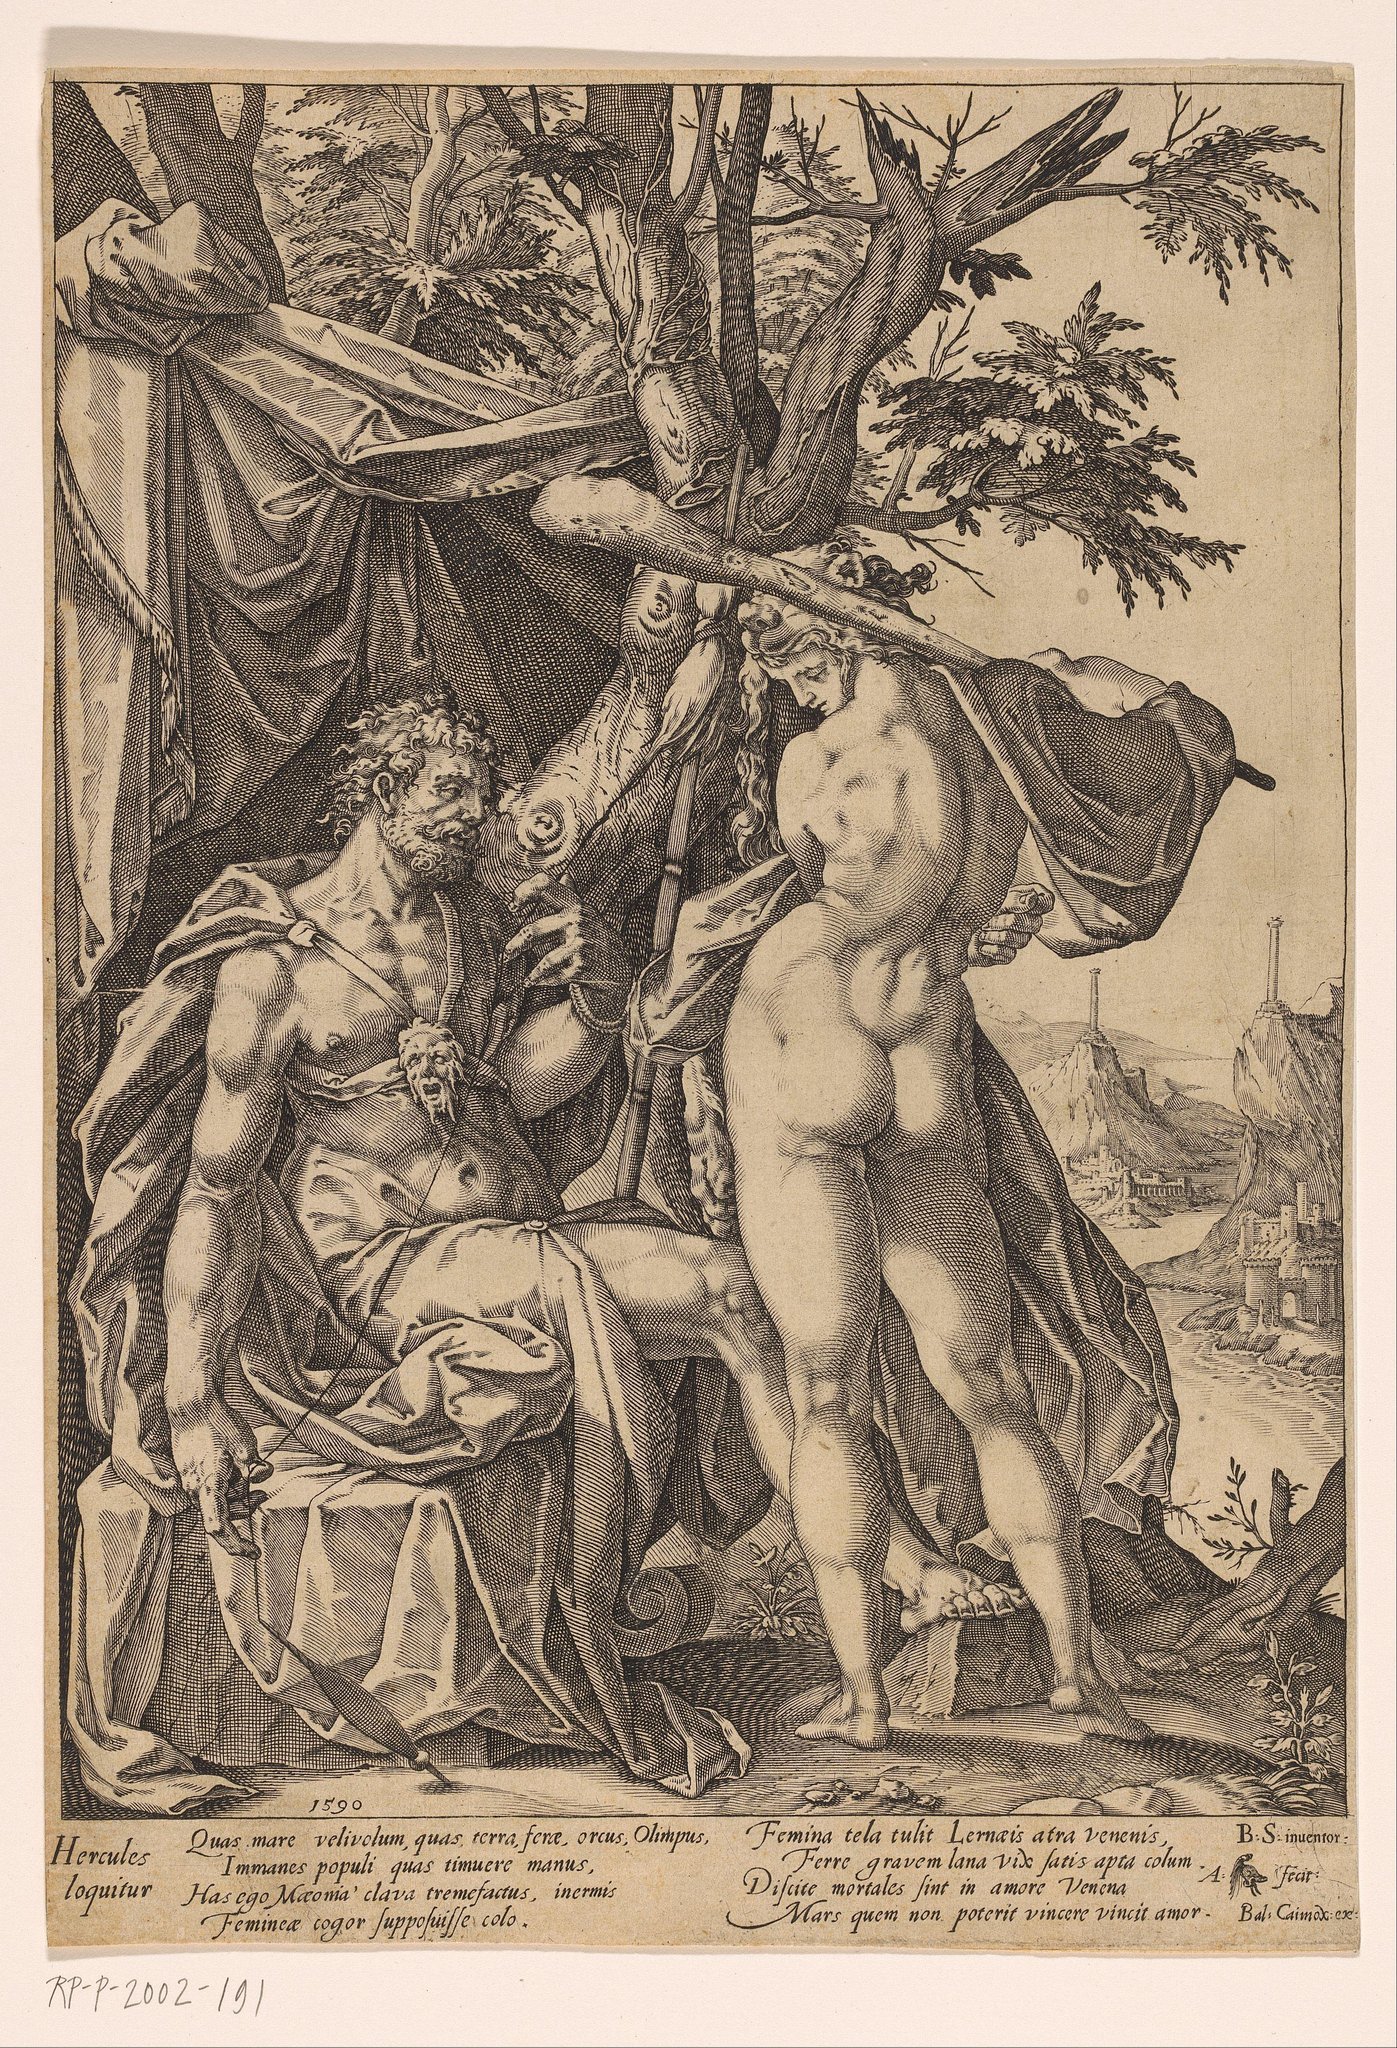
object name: print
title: Hercules en Omphale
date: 1590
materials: paper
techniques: engraving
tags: landscapes, hercules in love with omphale; the hero is set to spin wool or to do other women's work among the servants, while omphale wears his lion's skin and wields his club and bow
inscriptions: collector's mark: Lugt 2228, collector's mark: Lugt 2760